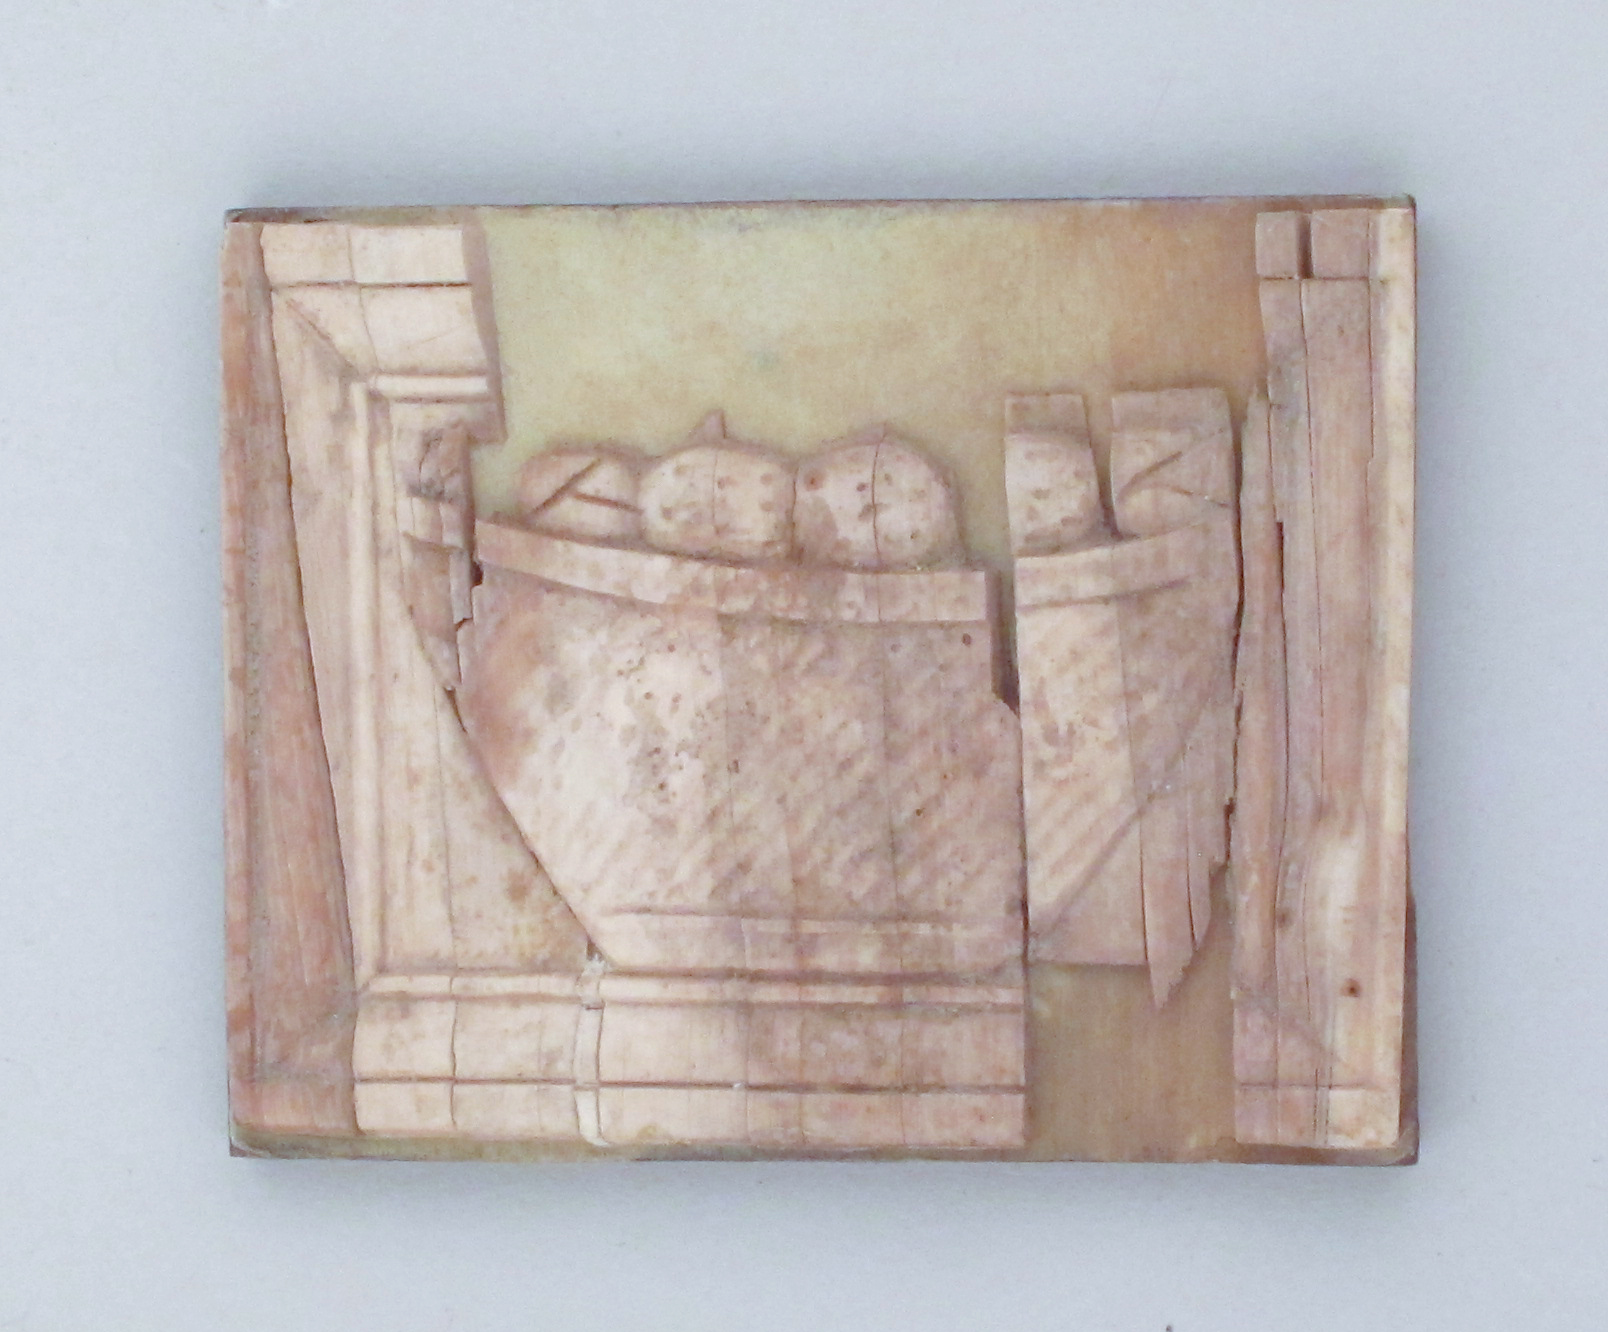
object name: relief from casket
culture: roman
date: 670 BCE-330 CE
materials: ivory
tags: fruit